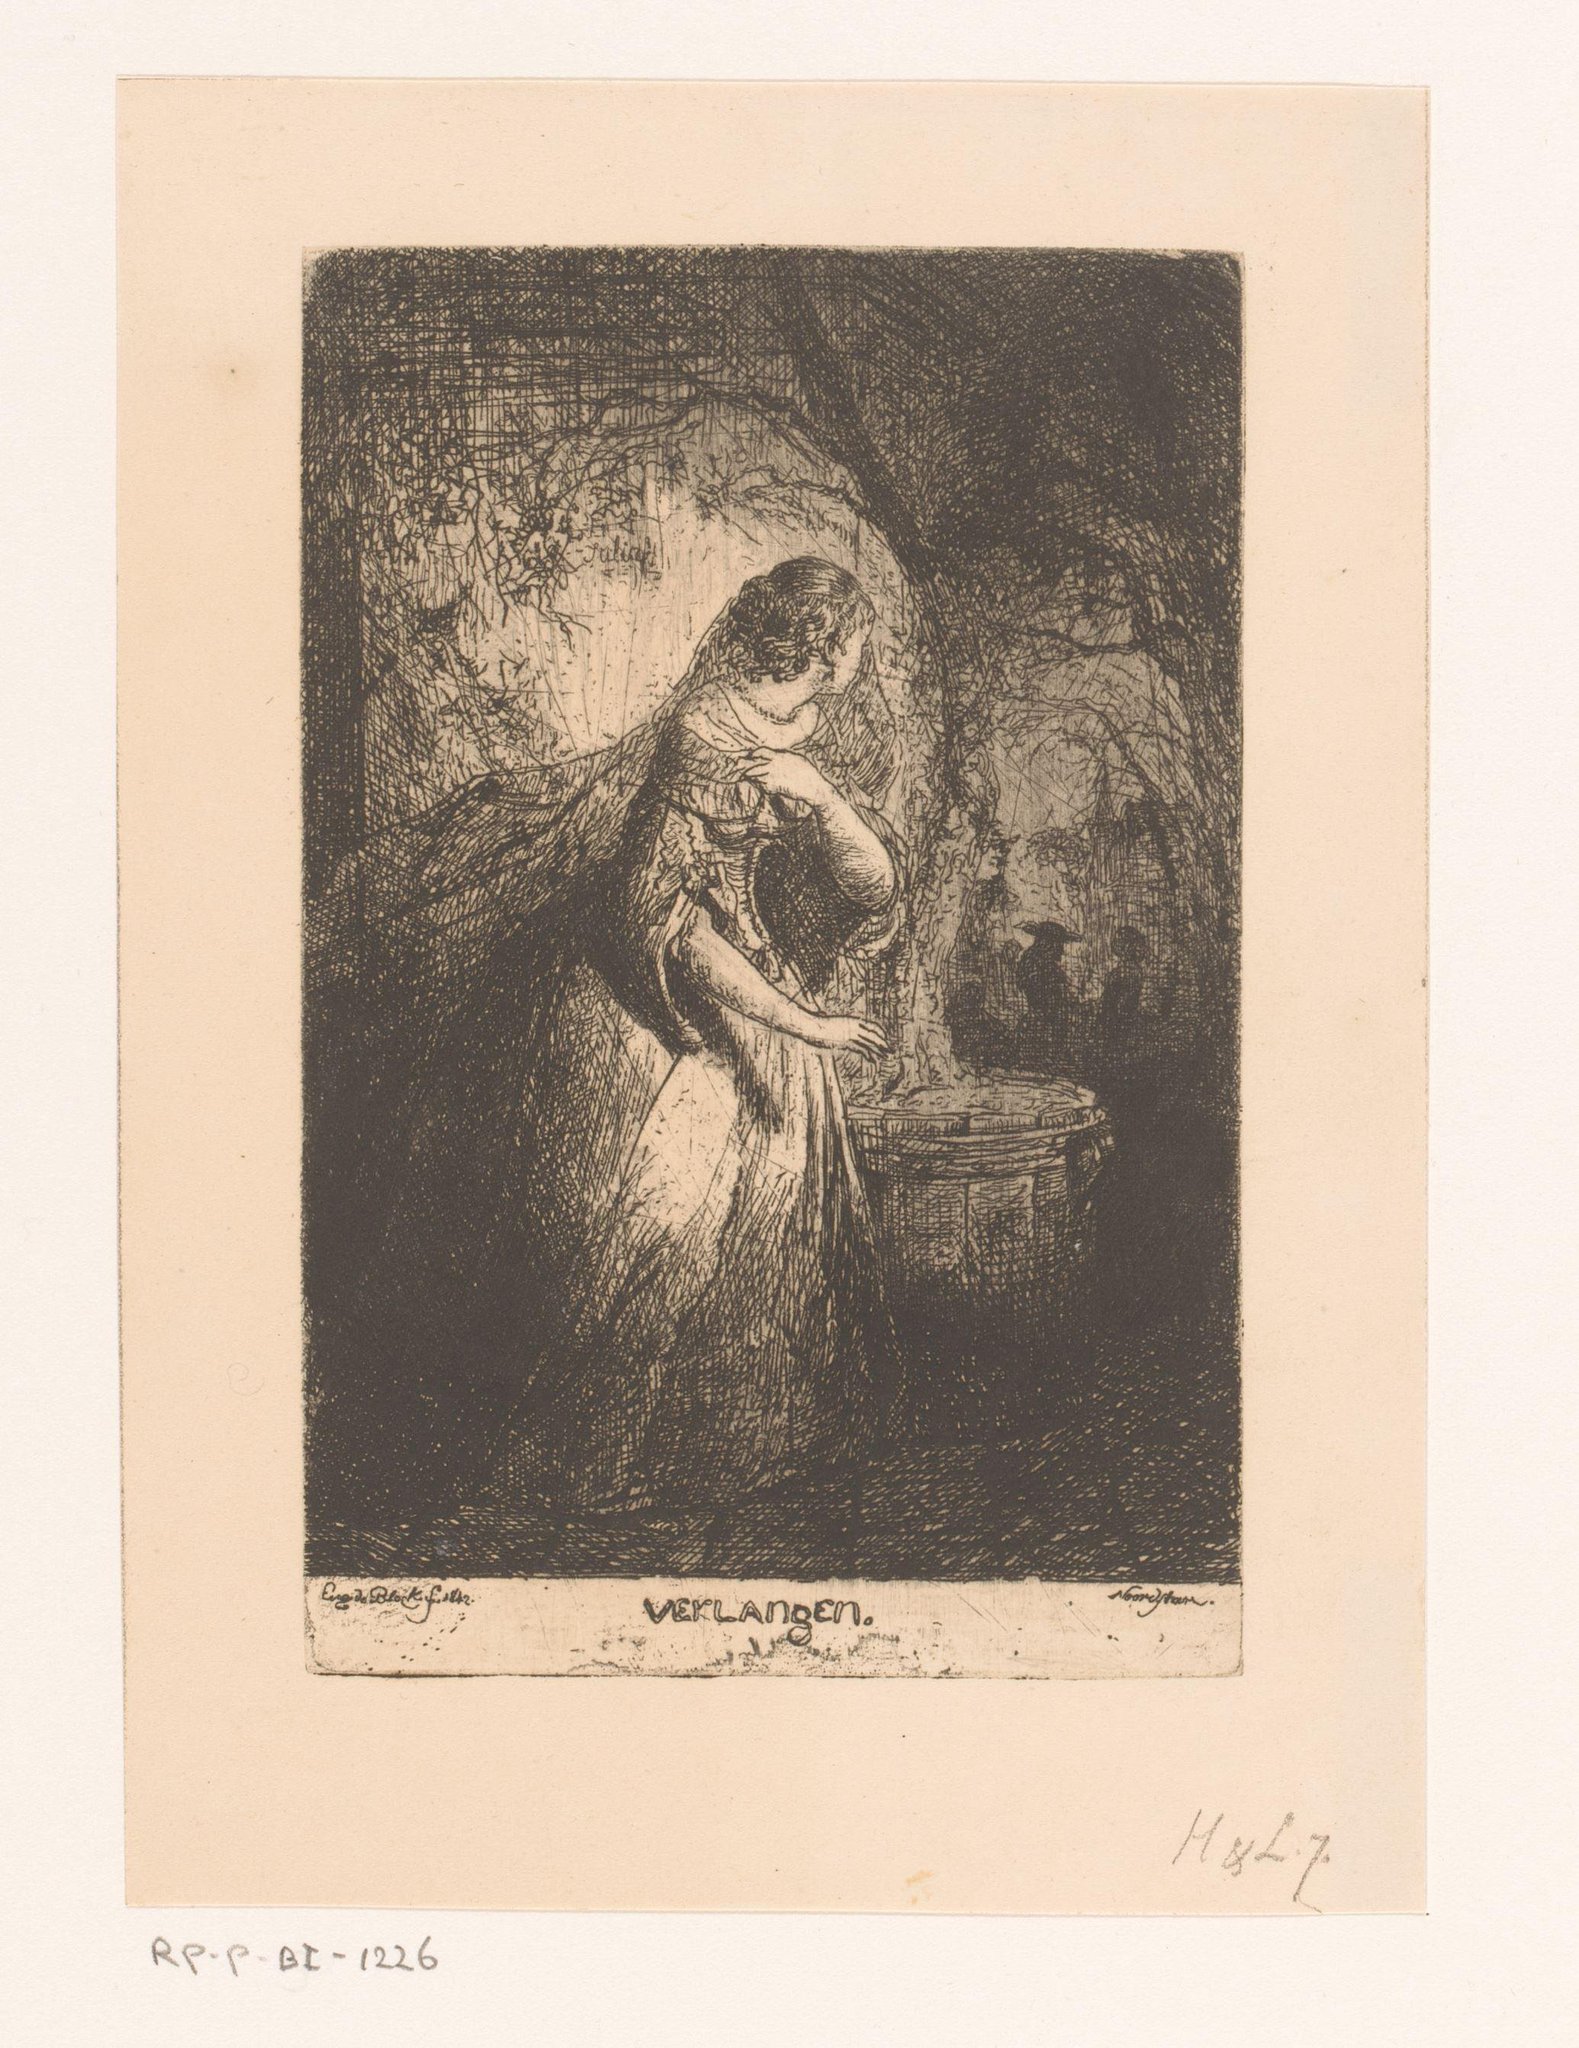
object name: print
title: Jonge vrouw in het bos, kijkend naar een koppel in de verte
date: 1842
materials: paper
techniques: etching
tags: adult woman, forest, wood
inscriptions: collector's mark: Lugt 2228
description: Jonge vrouw in het bos, kijkend naar een koppel in de verte. Boven de vrouw is de naam 'Julia' te lezen.